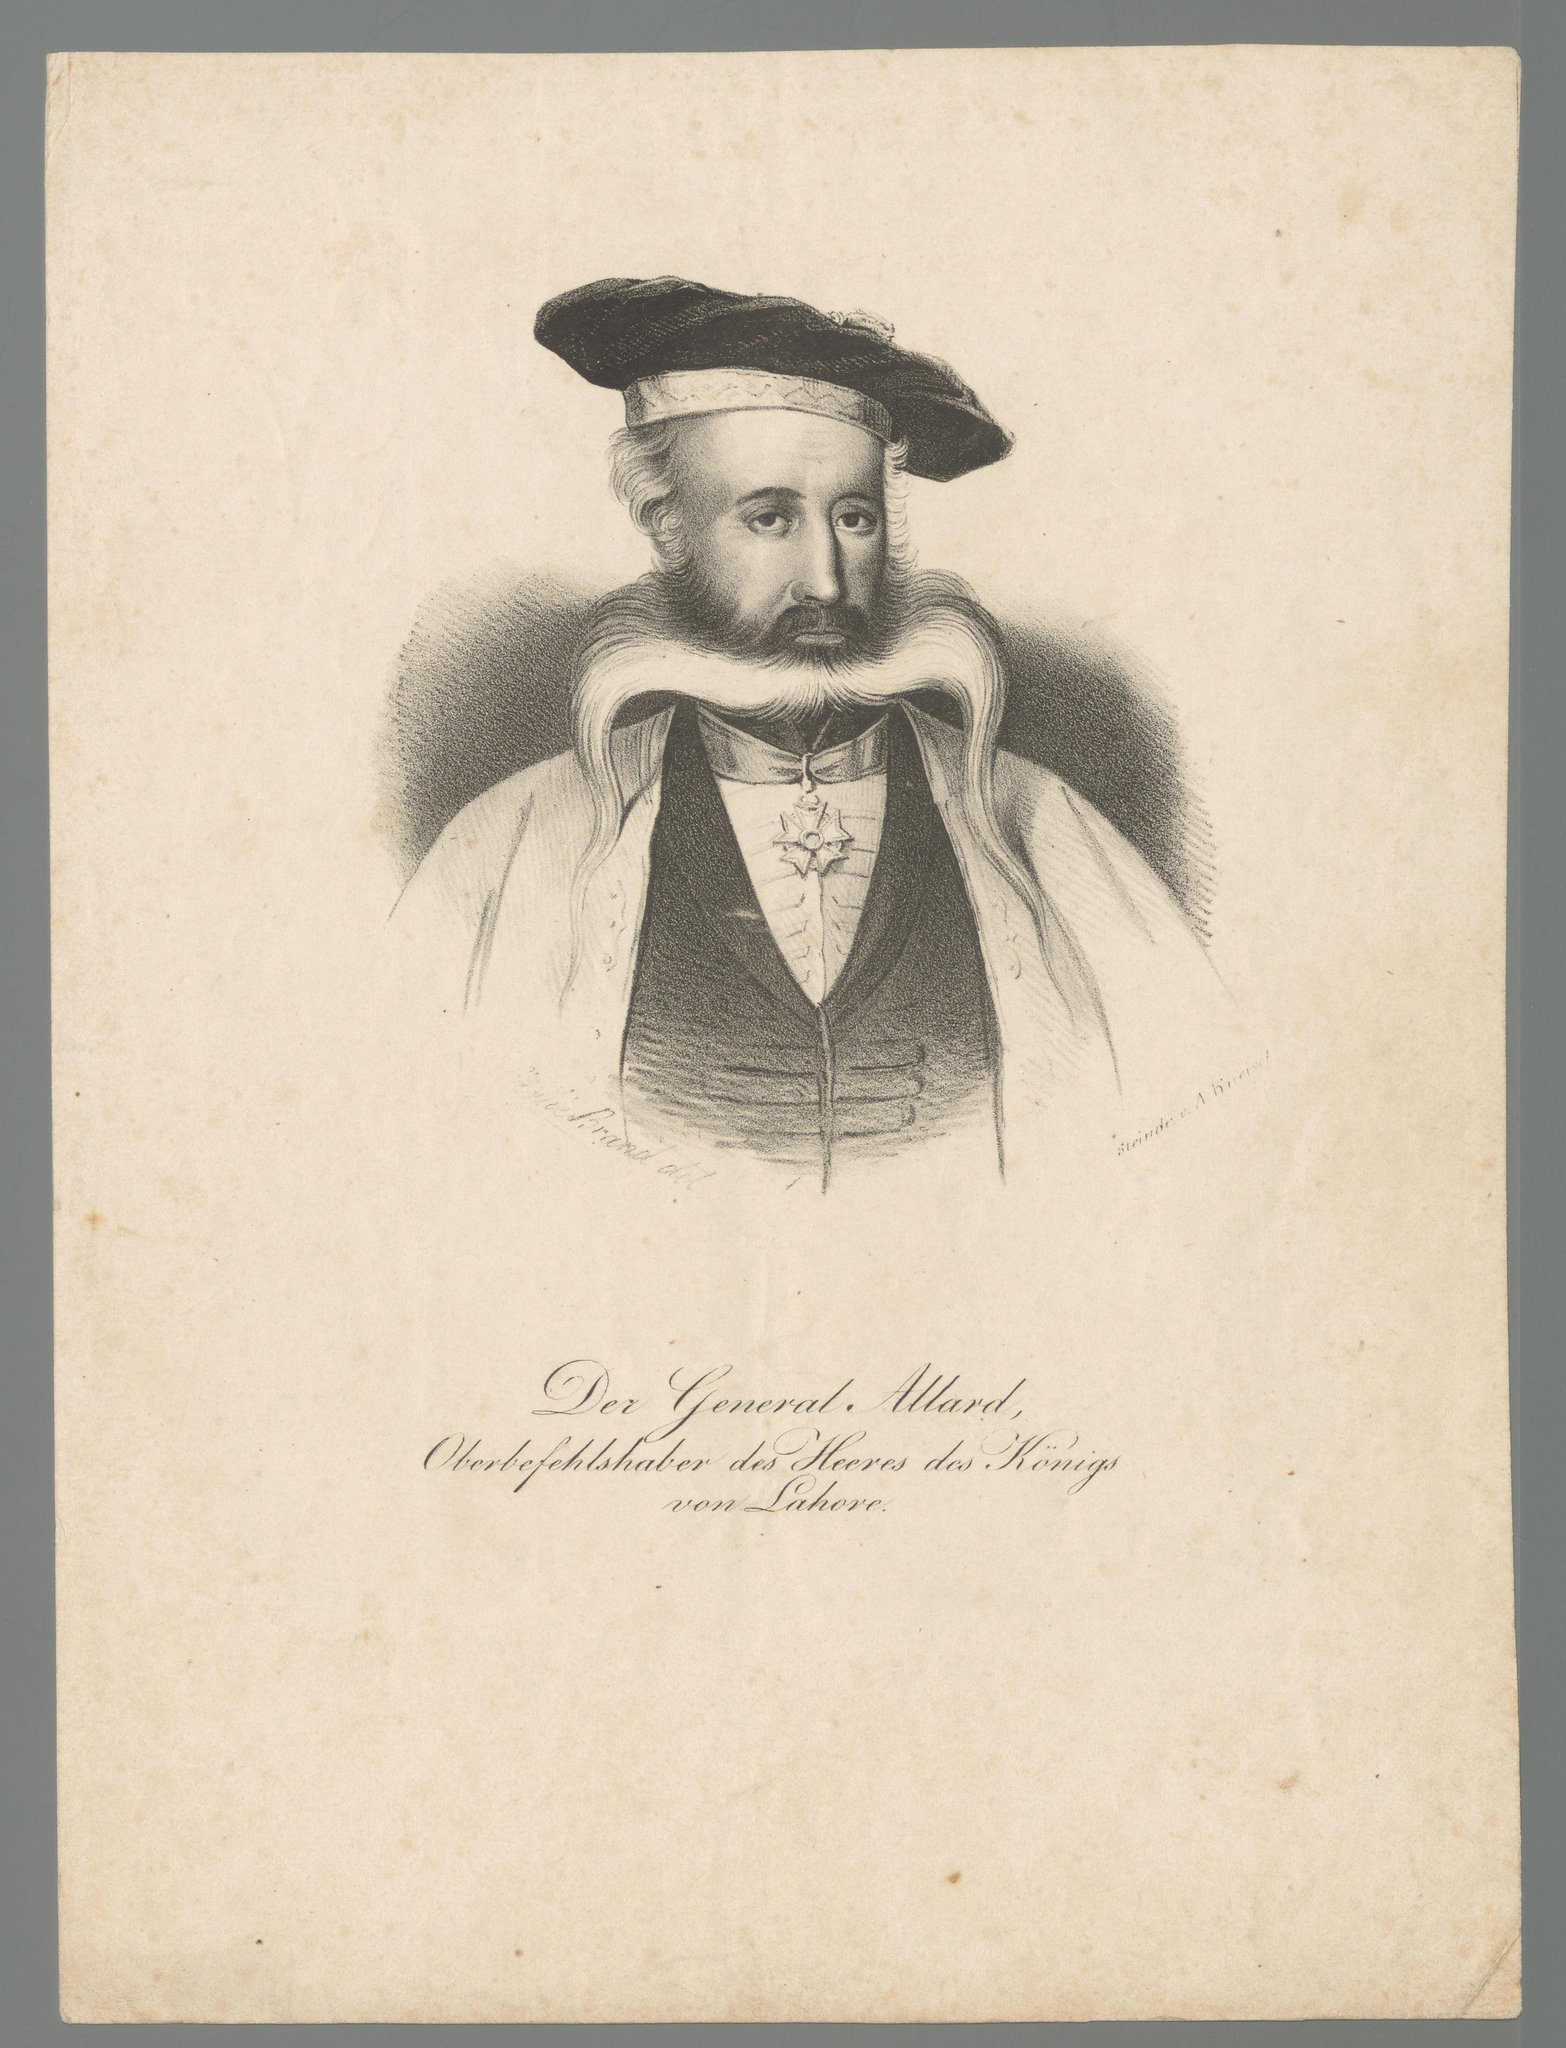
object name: print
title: Der General Allard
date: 1825-1850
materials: paper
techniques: lithograph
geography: leipzig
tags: adult man, historical persons, beard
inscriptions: collector's mark: Lugt 2228